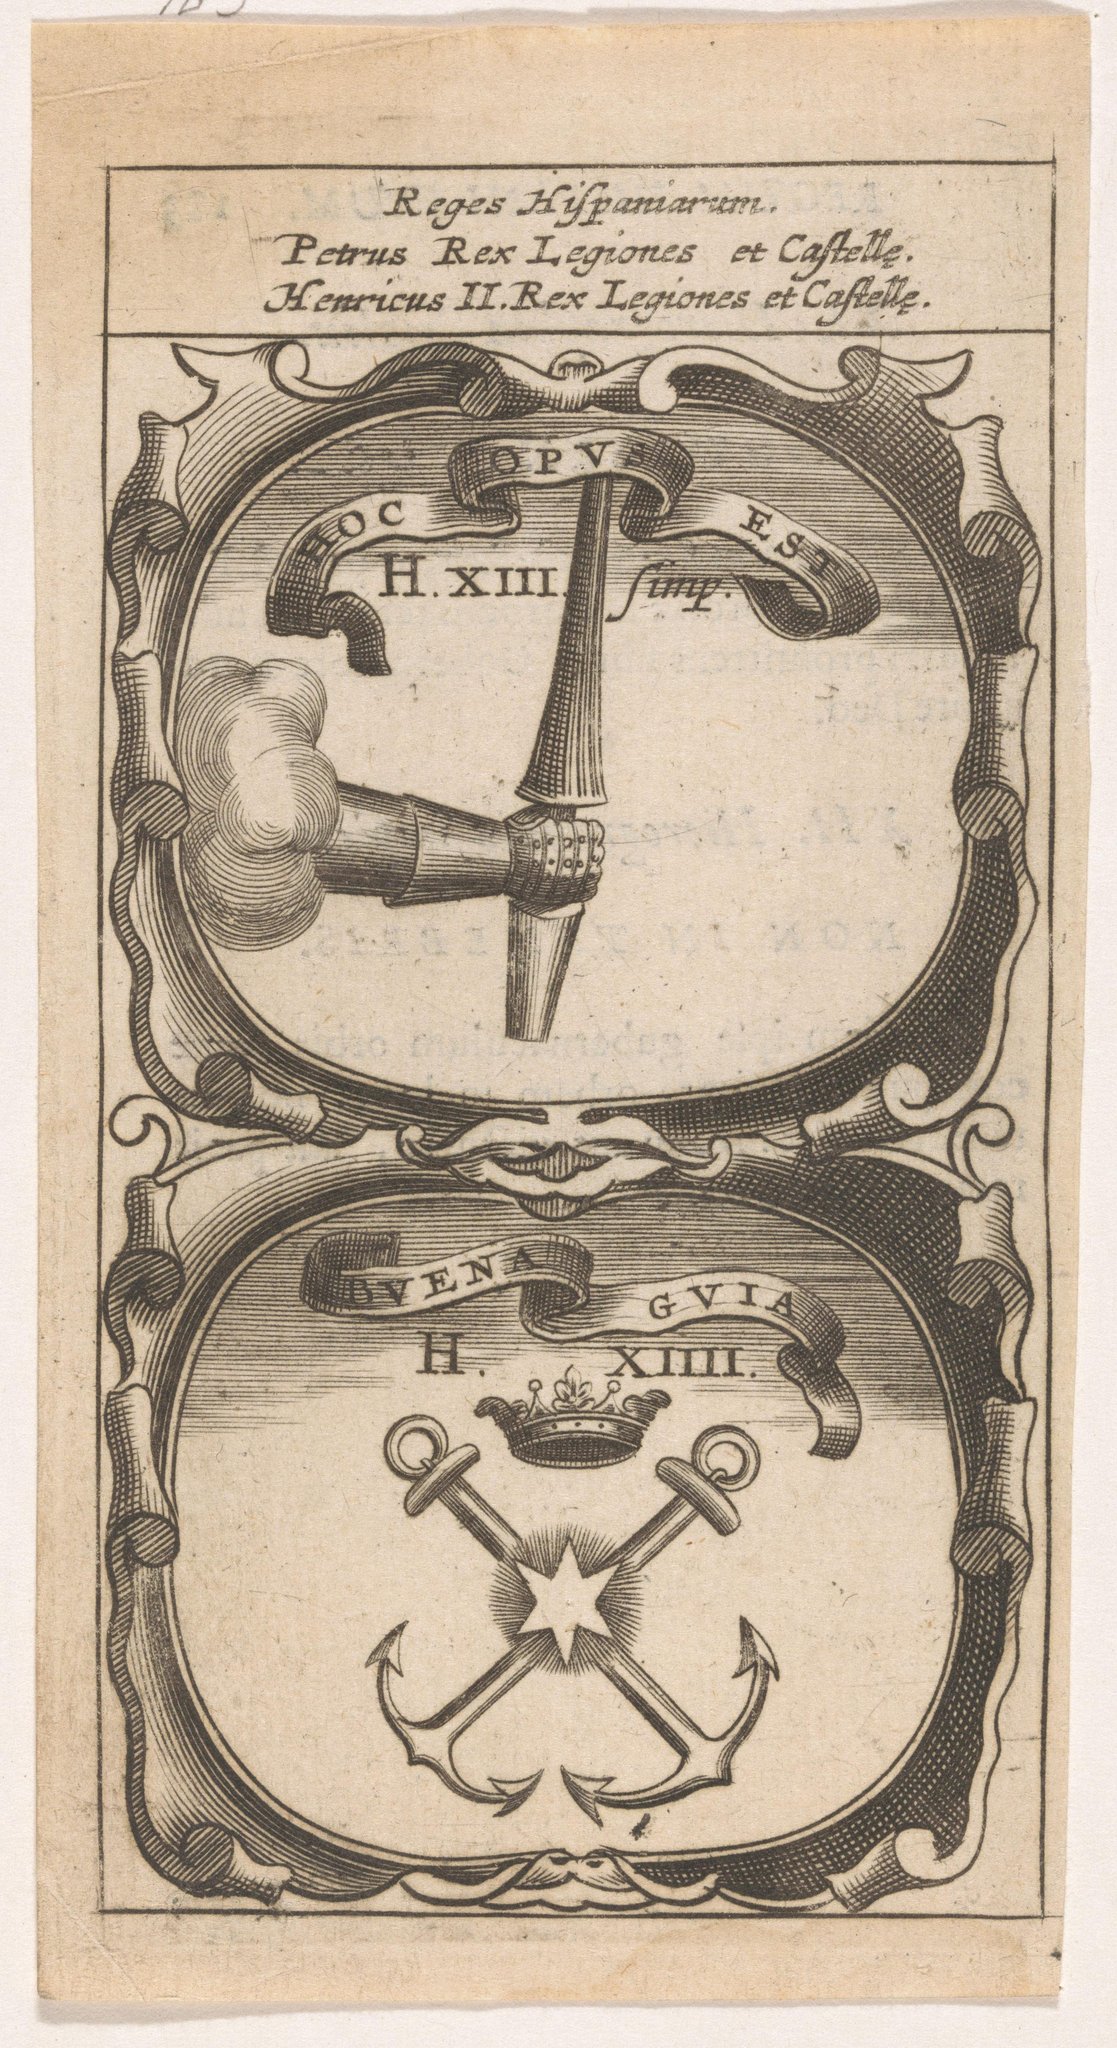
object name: print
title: Hand in de wolken met lans / Gekruiste ankers met ster en kroon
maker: Anonymous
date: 1666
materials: paper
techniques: engraving, letterpress printing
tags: helved weapons, polearms (for striking, hacking, thrusting): lance, postures and gestures of arms and hands, parts of ship's exterior: anchor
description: Pagina uit Jacob Typotius, Symbola Divina & Humana Pontificum Imperatorum Regum. Arnhem, J.F. Hagen, 1666 of uit de titeluitgave van 1669 of 1679. Het werk van Typotius werd voor het eerst uitgegeven in 1601 met prenten van Aegidius Sadeler.